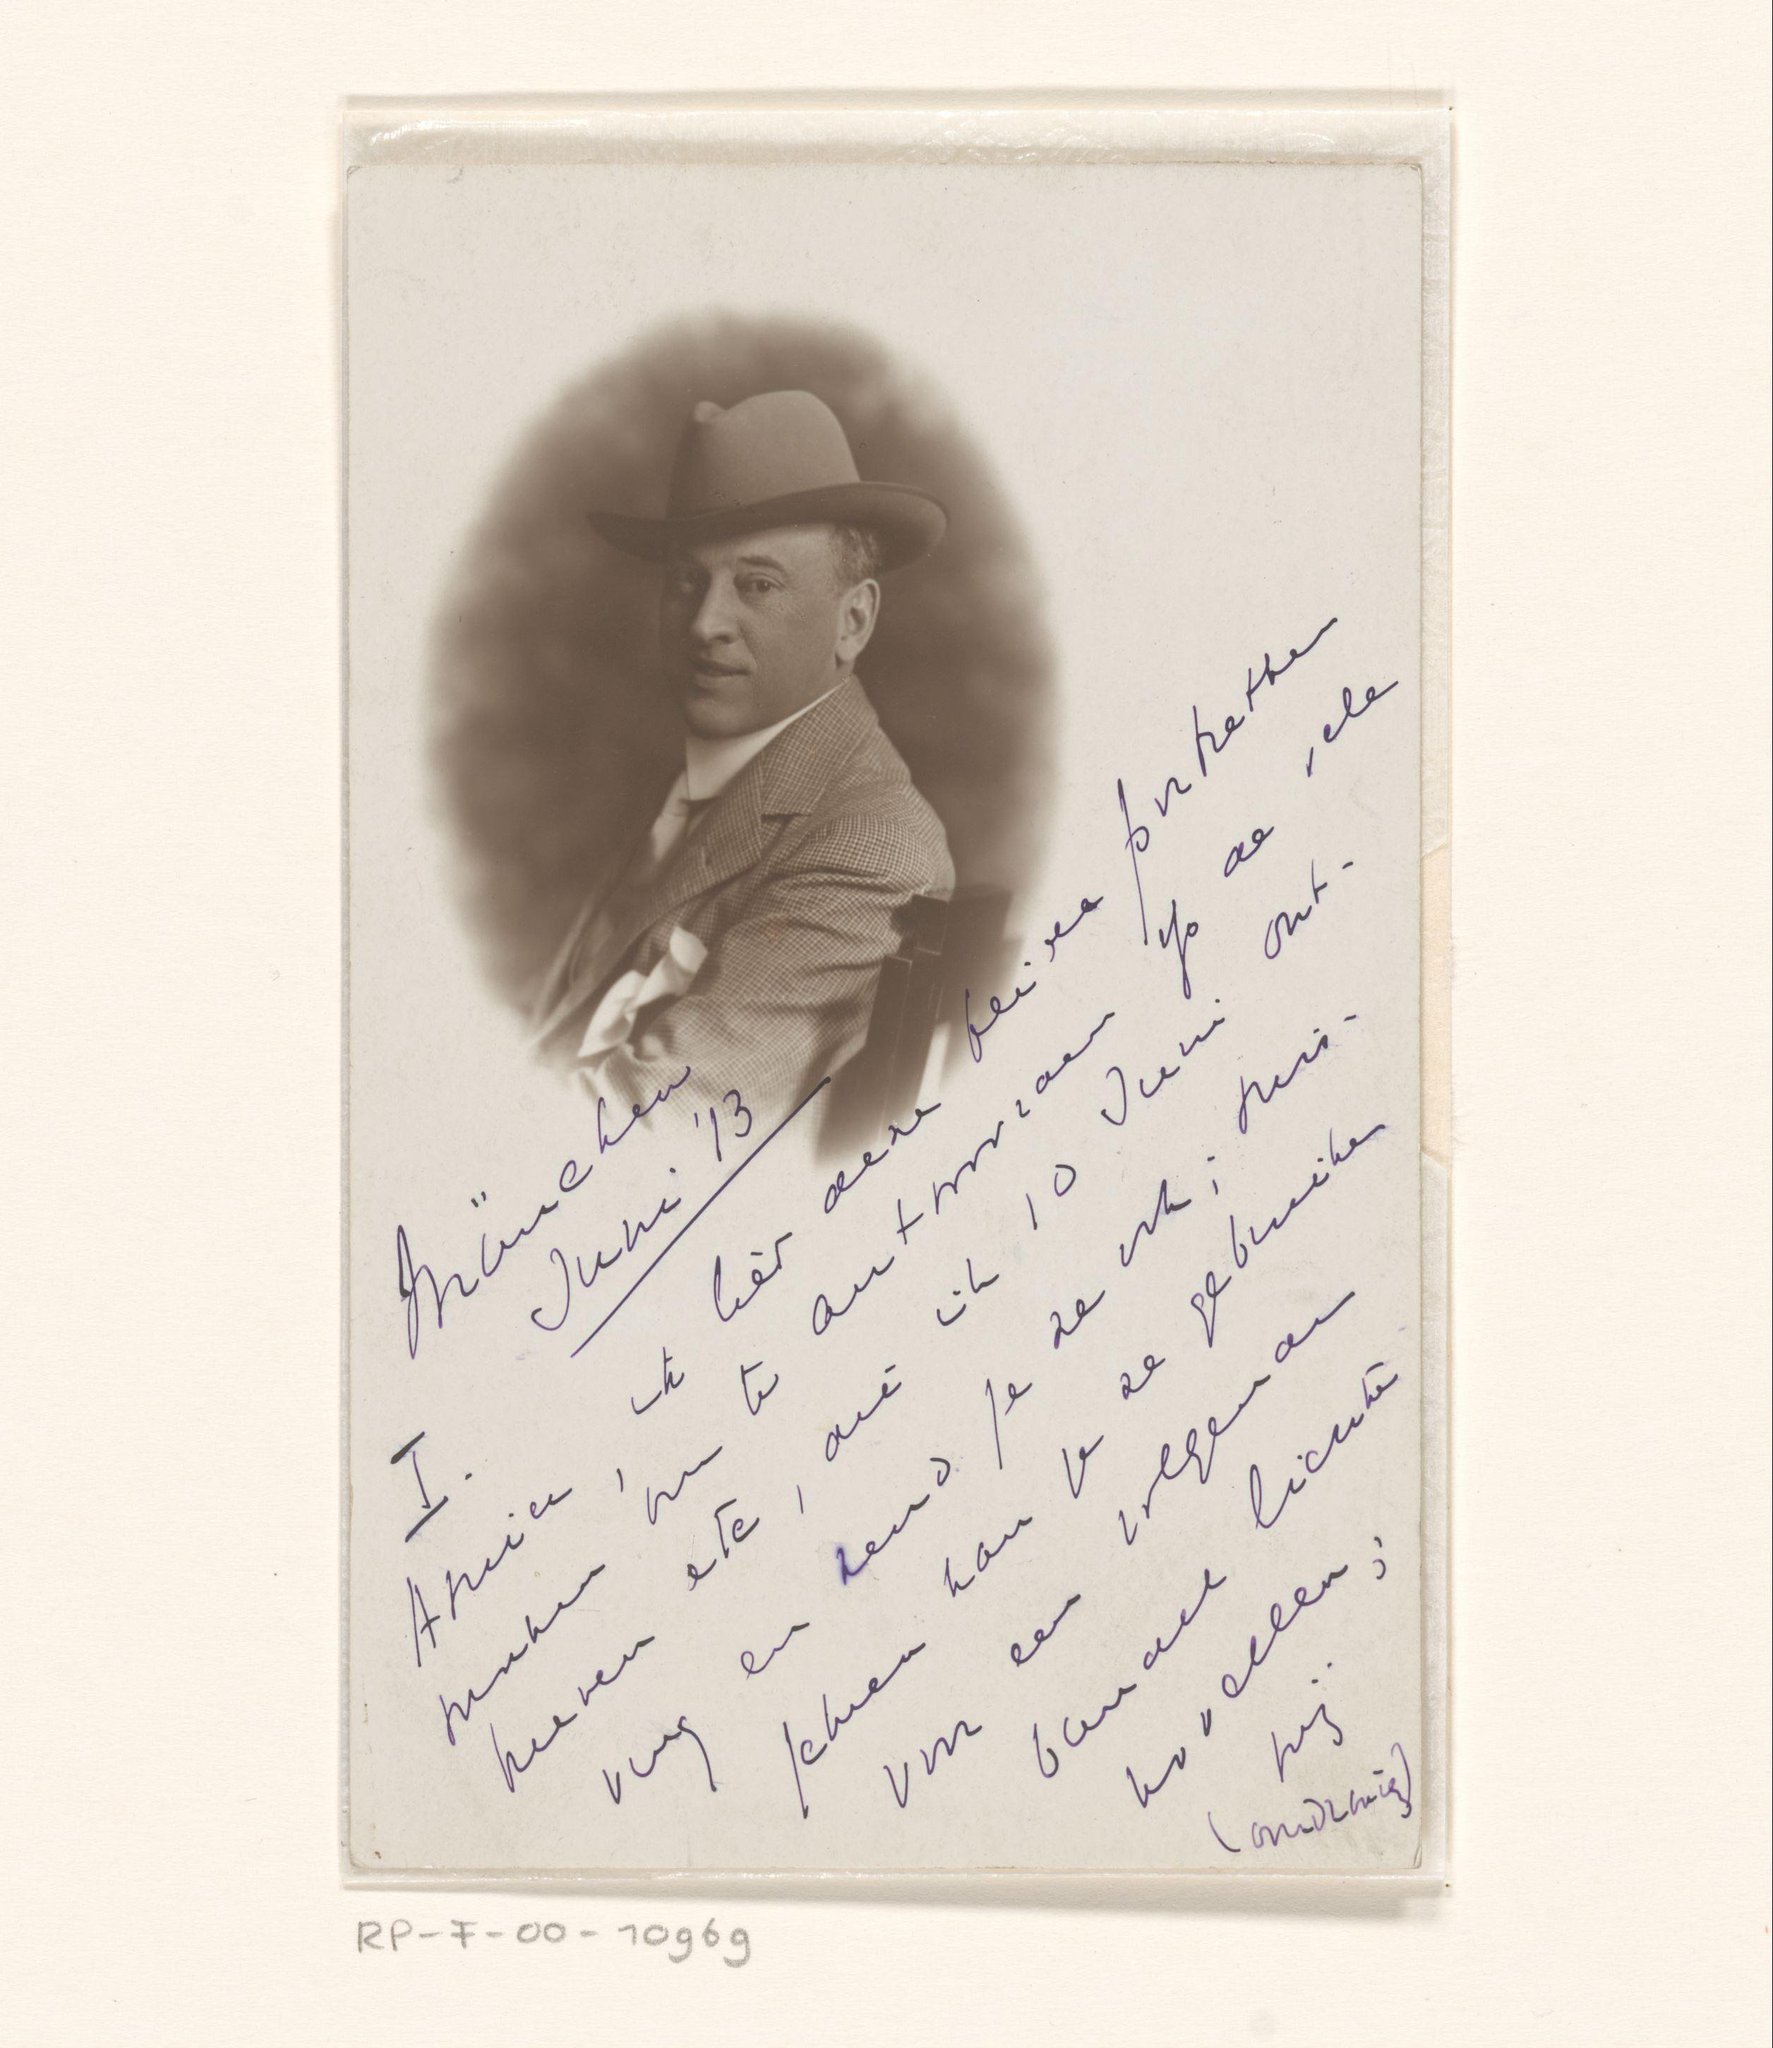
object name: postcard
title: Briefkaart met portretfoto, vermoedelijk aan Uitgeversmaatschappij L.J. Veen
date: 1906-1913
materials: ink, photographic support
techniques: gelatin silver print, pen, writing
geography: munich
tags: historical persons not known by name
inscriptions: annotation: ‘Veen’, collector's mark: Lugt 2228a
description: Vermoedelijk een portret van een schrijver.